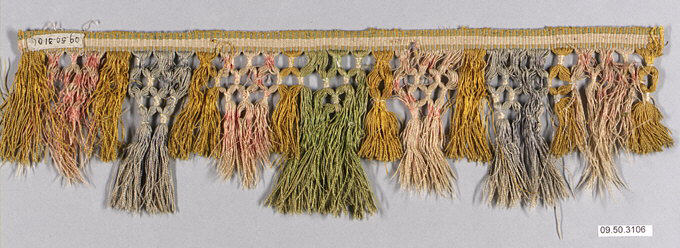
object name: fringe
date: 1701-1900